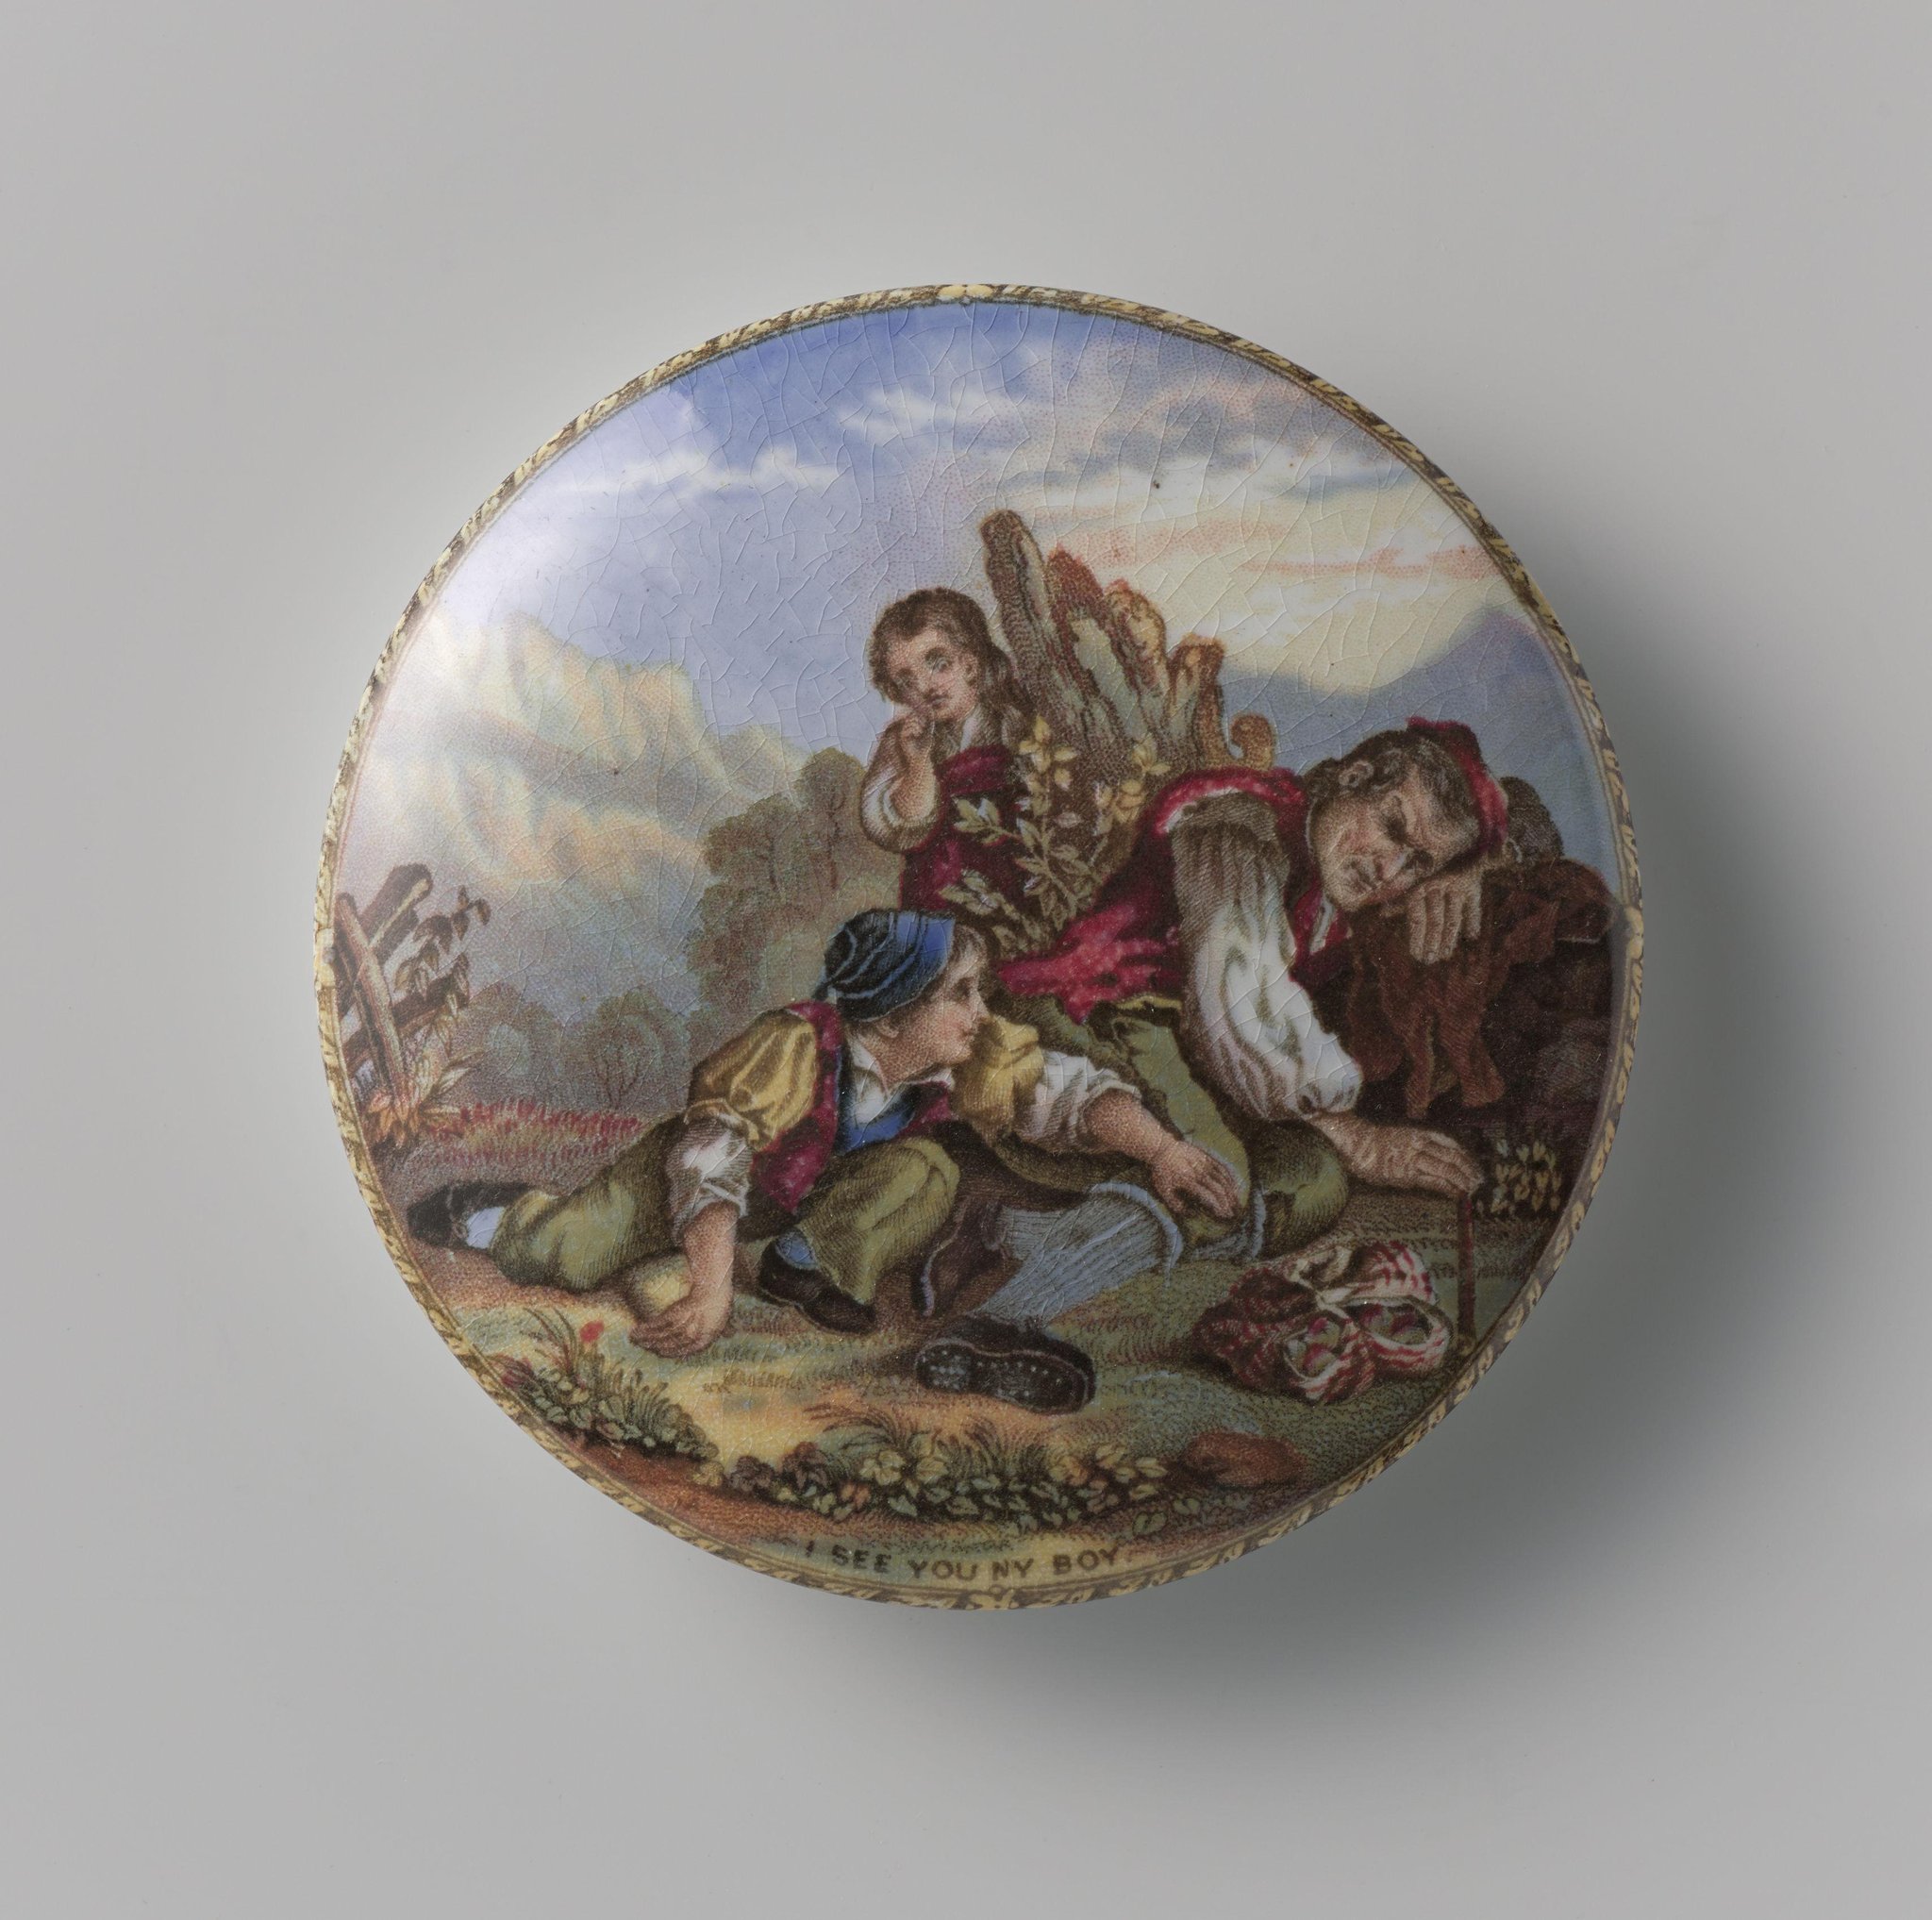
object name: pot lid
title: Potdeksel met decor: I see you my boy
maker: Anonymous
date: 1400-1950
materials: earthenware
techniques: transfer decoration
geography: staffordshire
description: Potdeksel van aardewerk met veelkleurig transferdecor, met een voorstelling van een man die doet alsof hij slaapt, terwijl een jongen iets probeert te stelen uit zijn knapzak. Een meisje kijkt toe van achter een boomstronk.